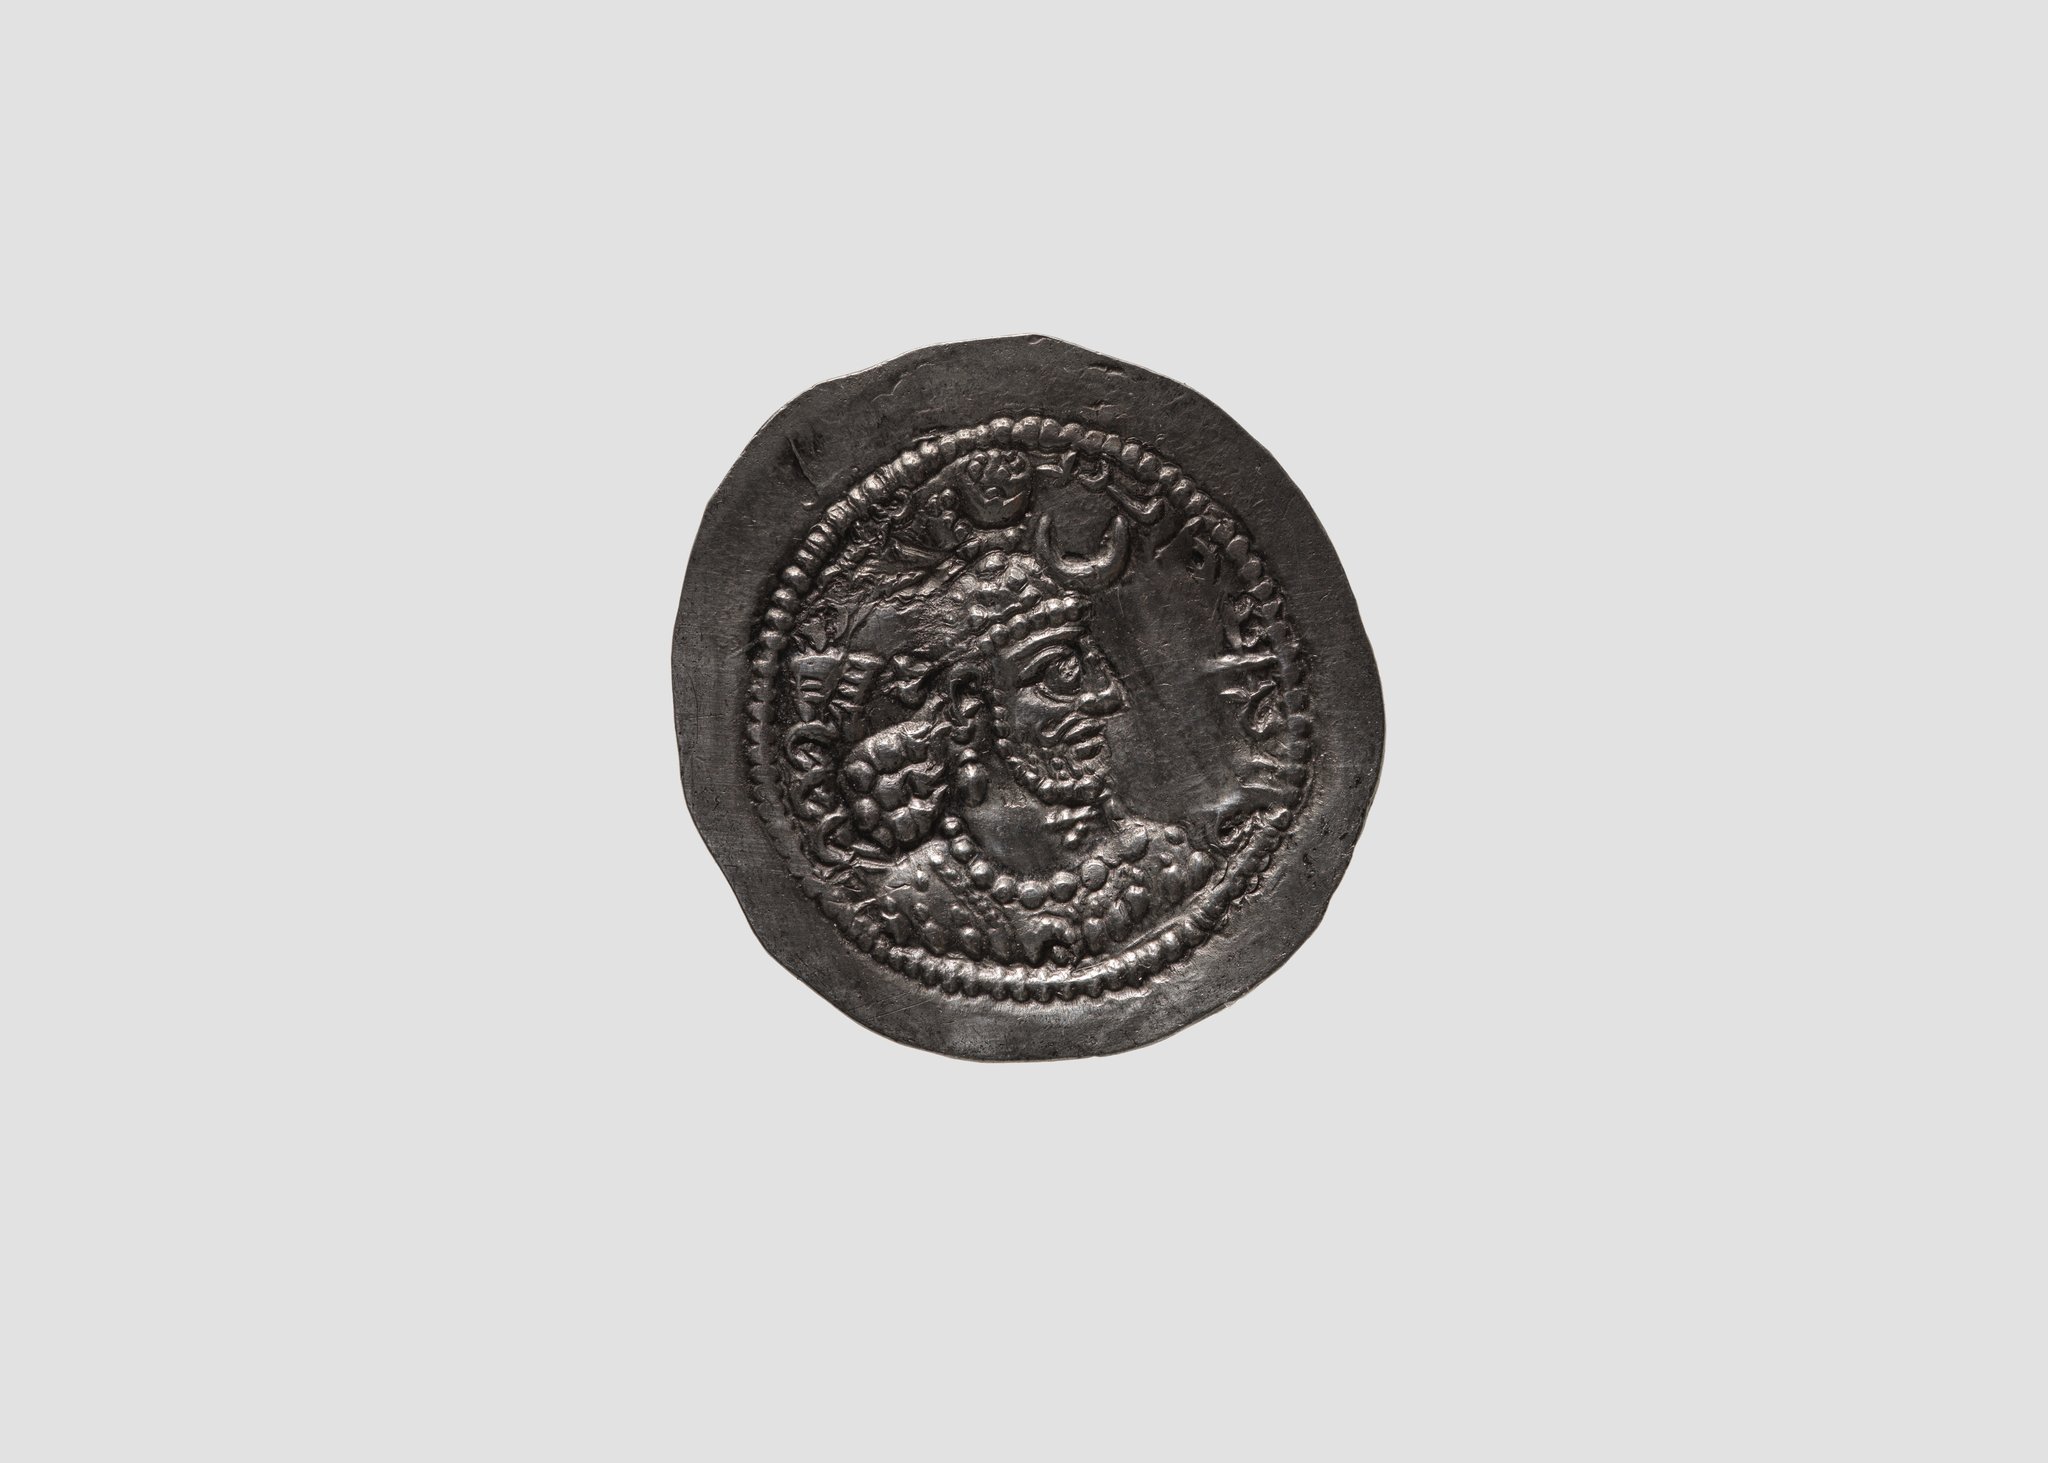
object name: coin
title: Drachm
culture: sasanian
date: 399-420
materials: silver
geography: iran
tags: men